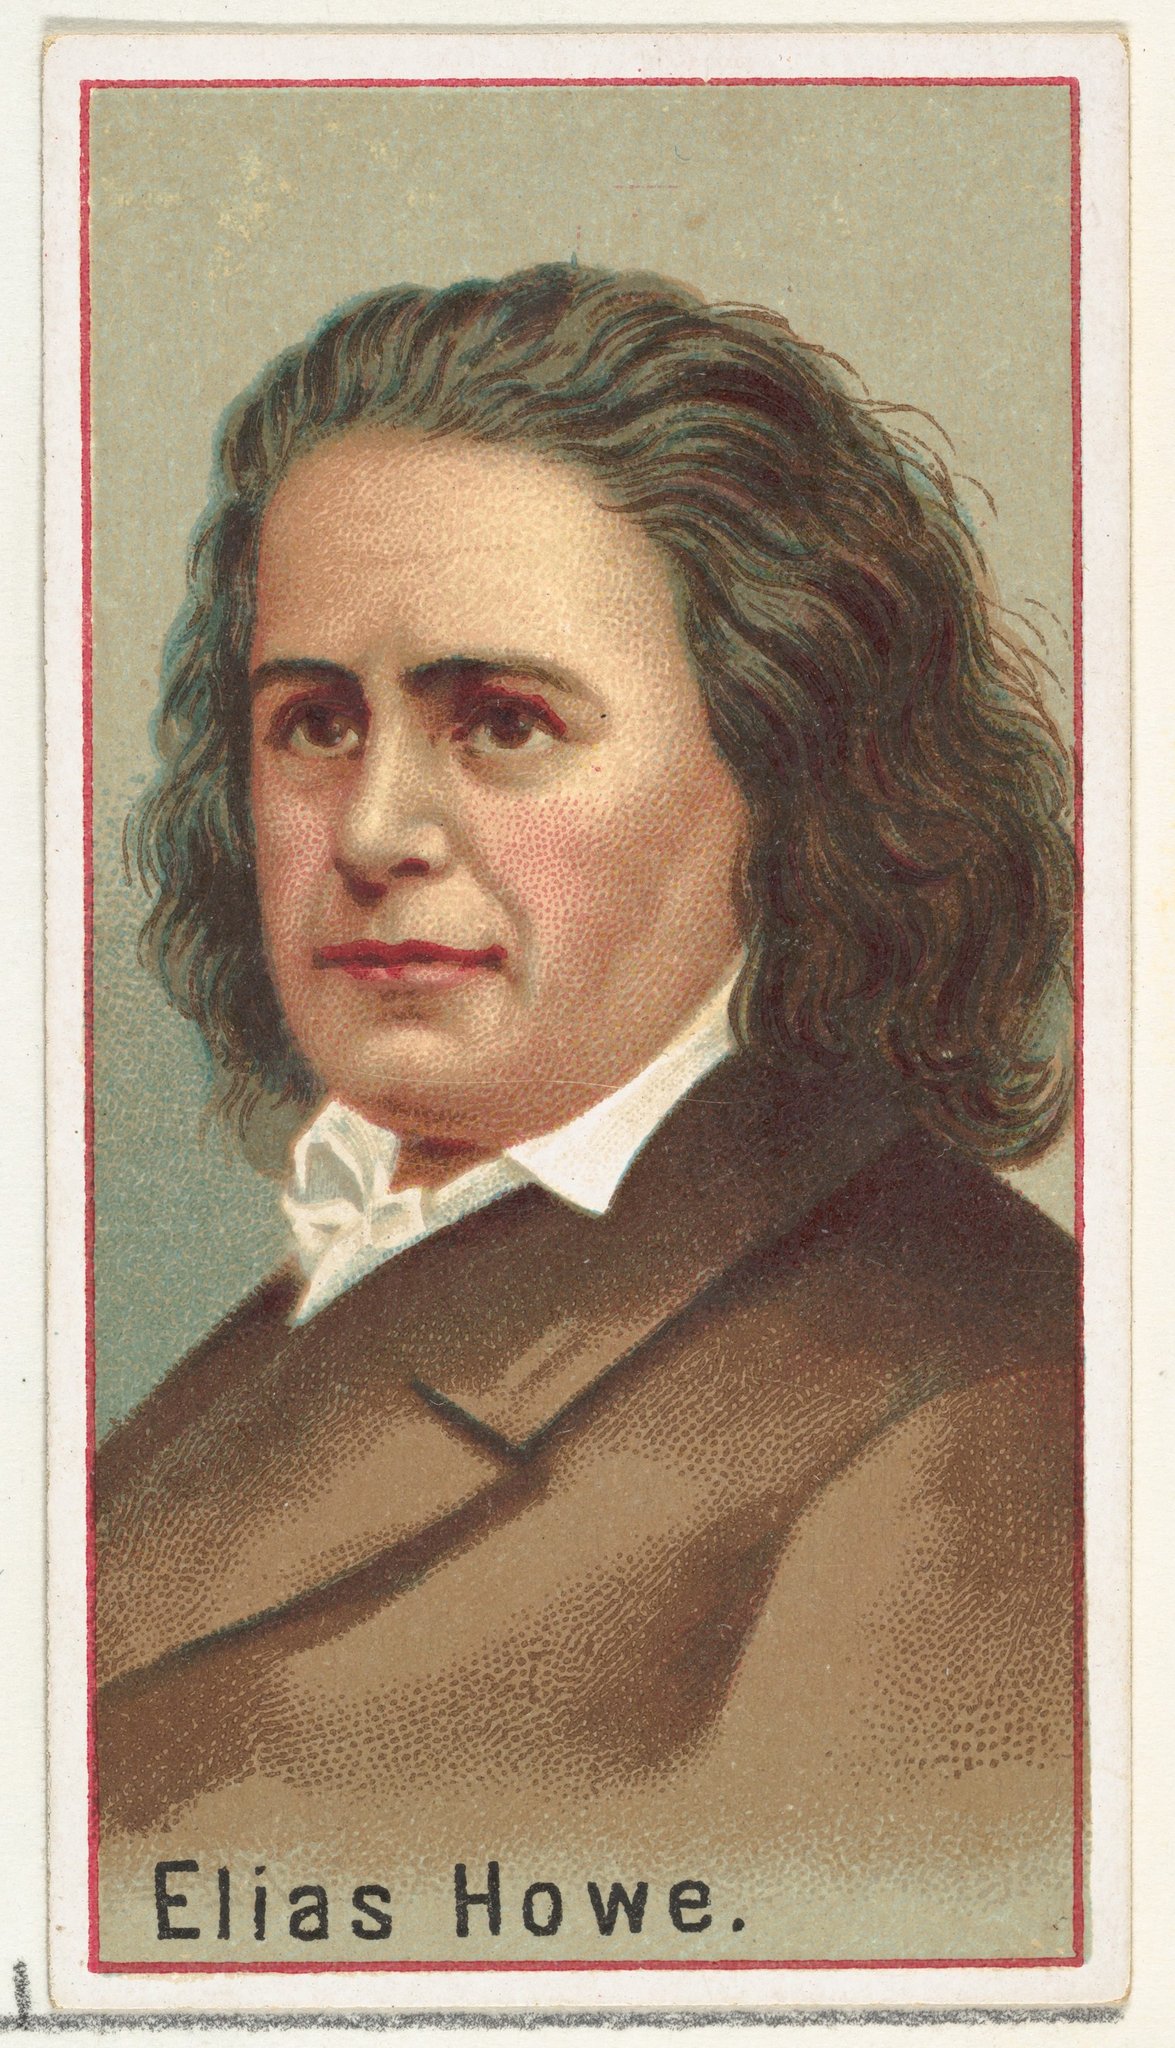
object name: print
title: Elias Howe, printer's sample for the World's Inventors souvenir album (A25) for Allen & Ginter Cigarettes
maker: allen & ginter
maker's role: publisher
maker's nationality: american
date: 1888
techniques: color lithograph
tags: men,portraits